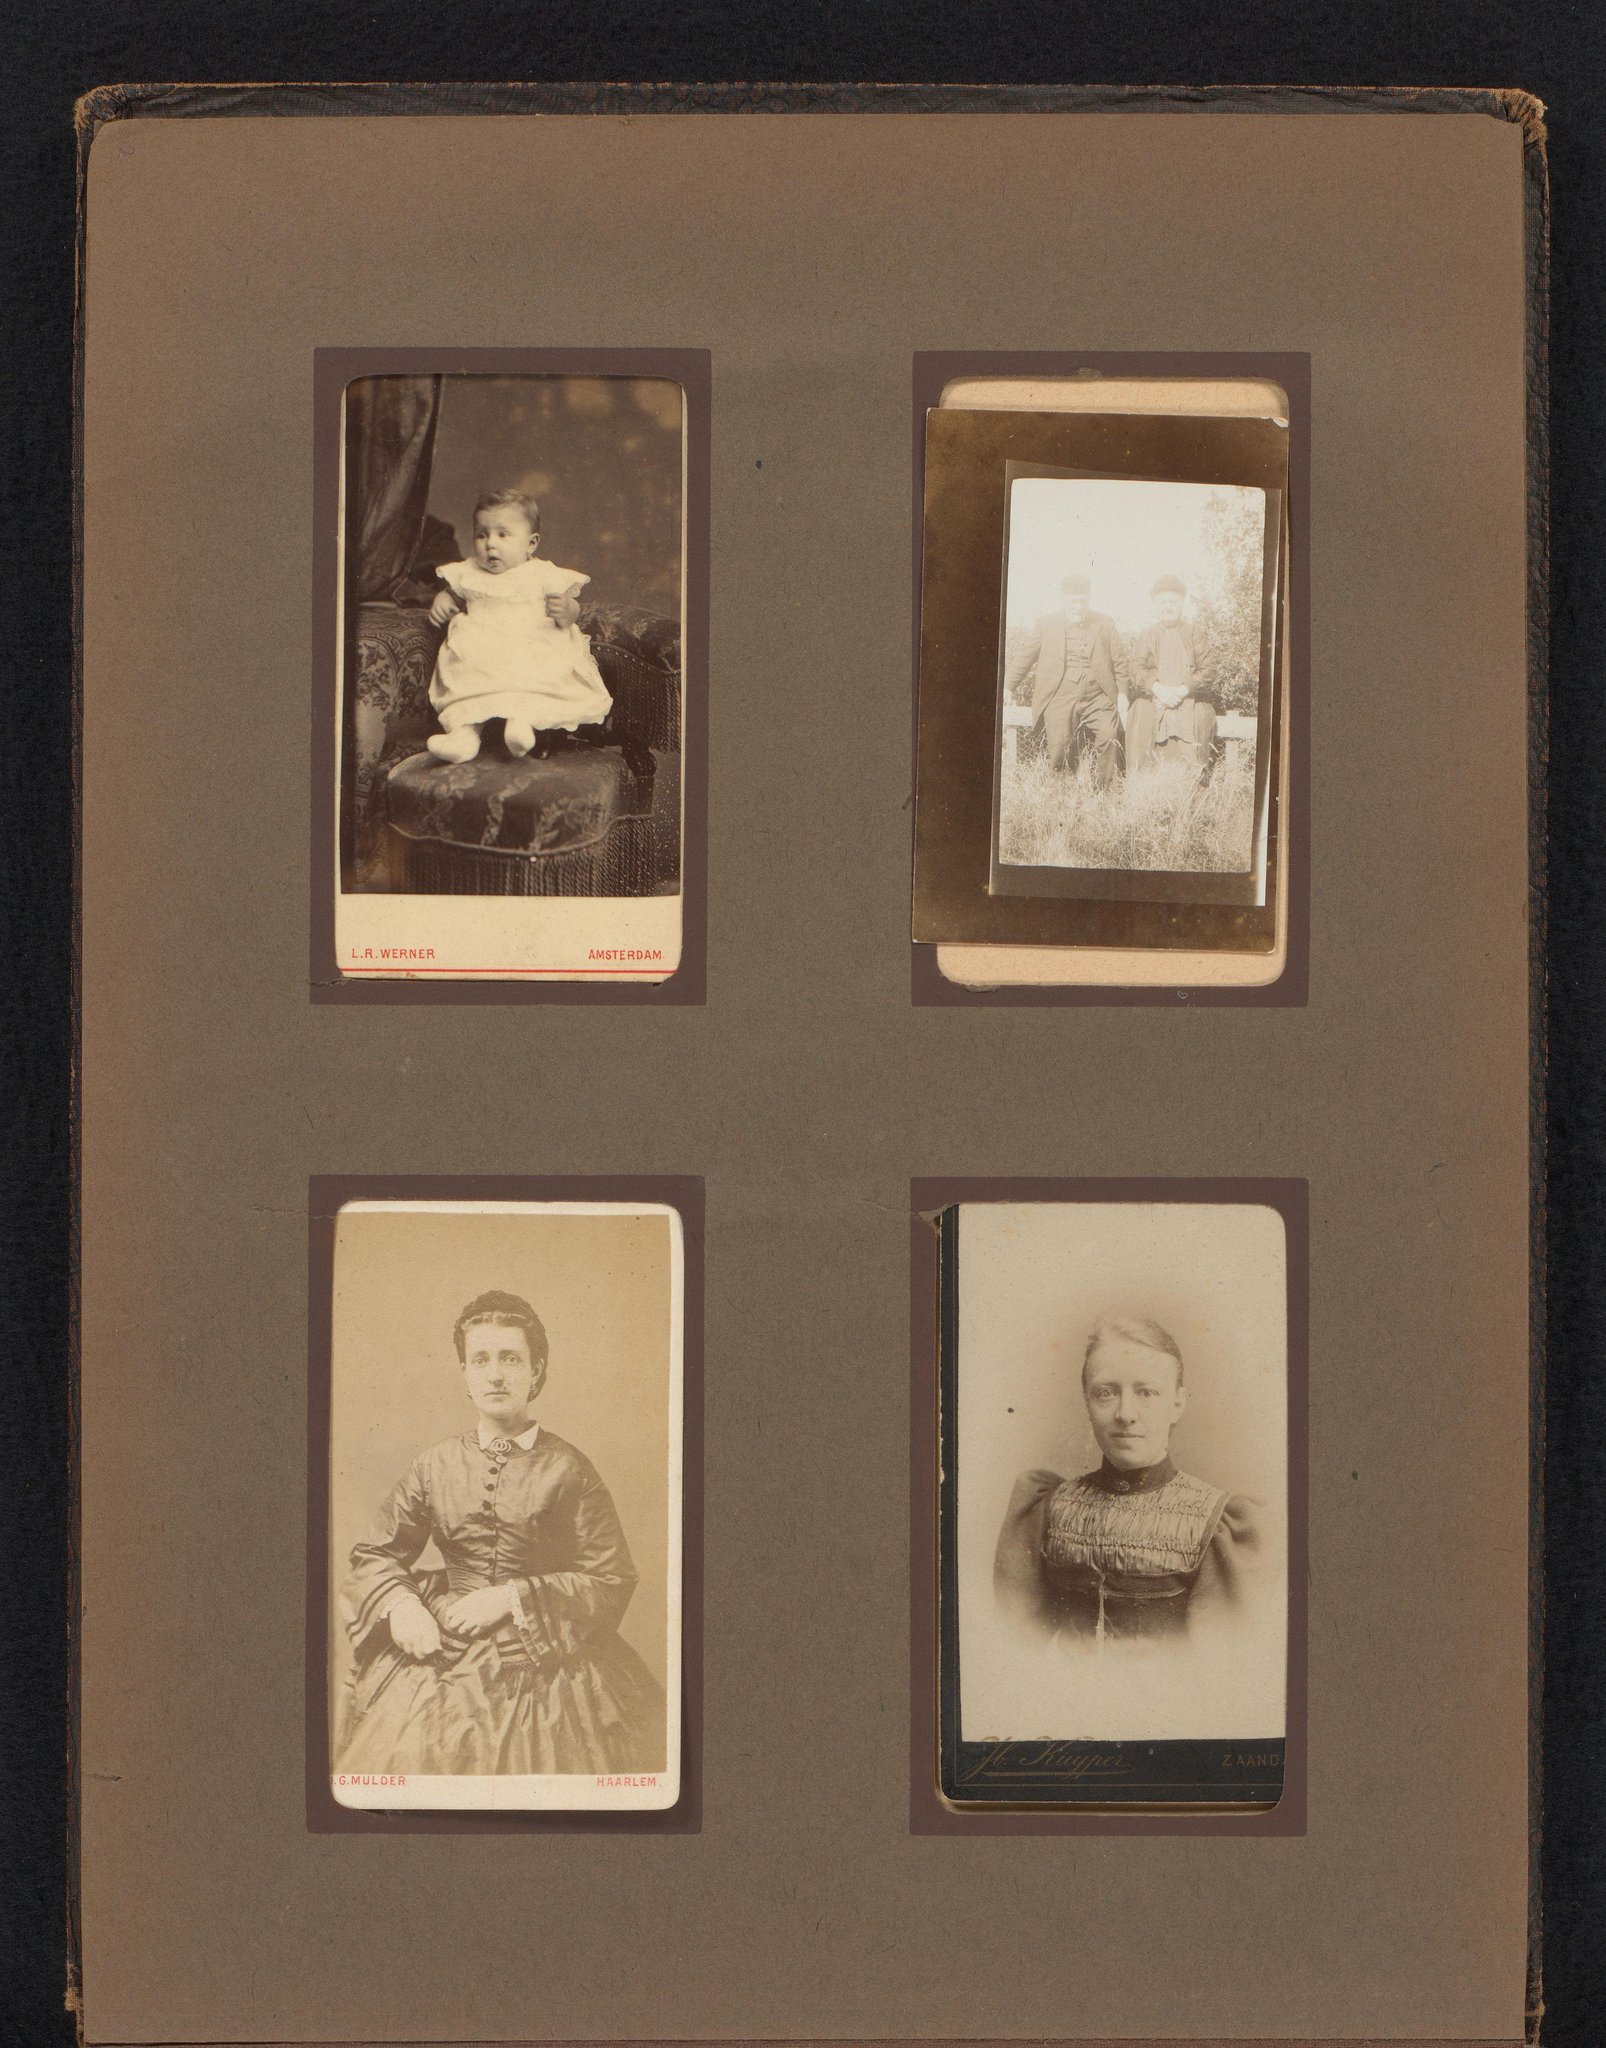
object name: photograph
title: Vier foto's met portretten, onder andere van Petrus Hermanus Bon en Guurtje van Leijden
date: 1860-1900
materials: paper, cardboard, celluloid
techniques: albumen print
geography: zaandam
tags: amsterdam, historical persons not known by name - bb - woman, historical persons not known by name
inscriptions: inscription: ‘P.H. Bon en/ zijn vrouw/ Guurtje Bon-/ van Leijden’, inscription: ‘L.R. Werner/ H.150/ Nieuwendijk/ Amsterdam’, inscription: ‘Photographie/ artistique/ Jb. Kuyper/ Vergrooting naar alle bestaande Photographien.’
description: Deze foto's maken deel uit van een album.